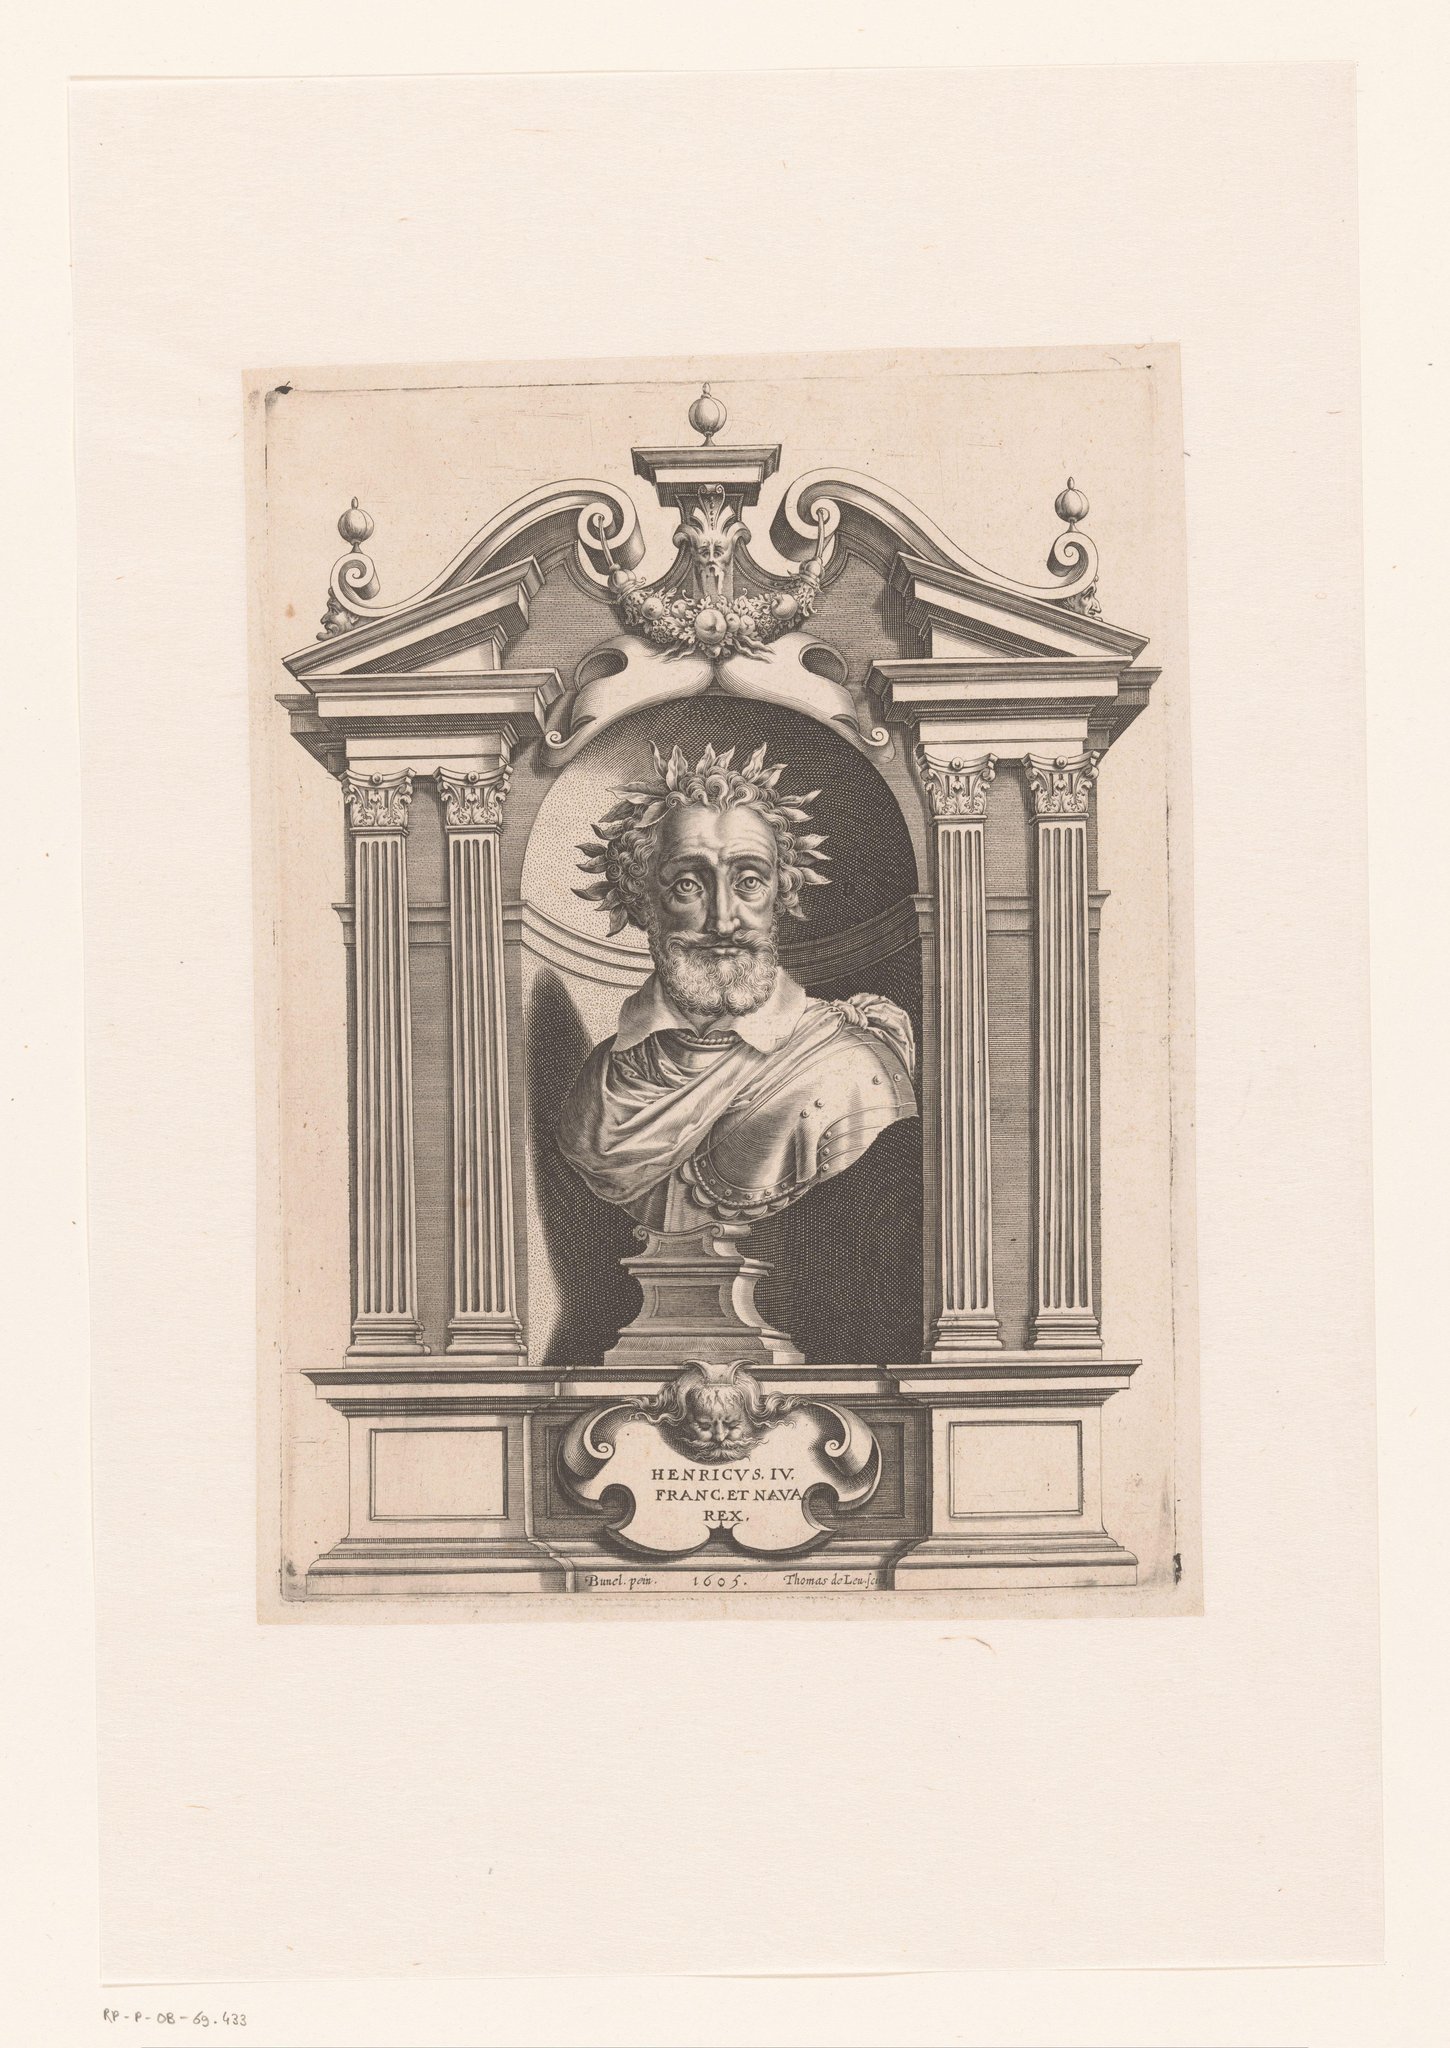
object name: print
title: Gelauwerde buste van Hendrik IV in een nis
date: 1605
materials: paper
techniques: engraving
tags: paris, hendrik iv (koning van frankrijk en navarra), historical persons, piece of sculpture, reproduction of a piece of sculpture, crowning with laurel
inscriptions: date